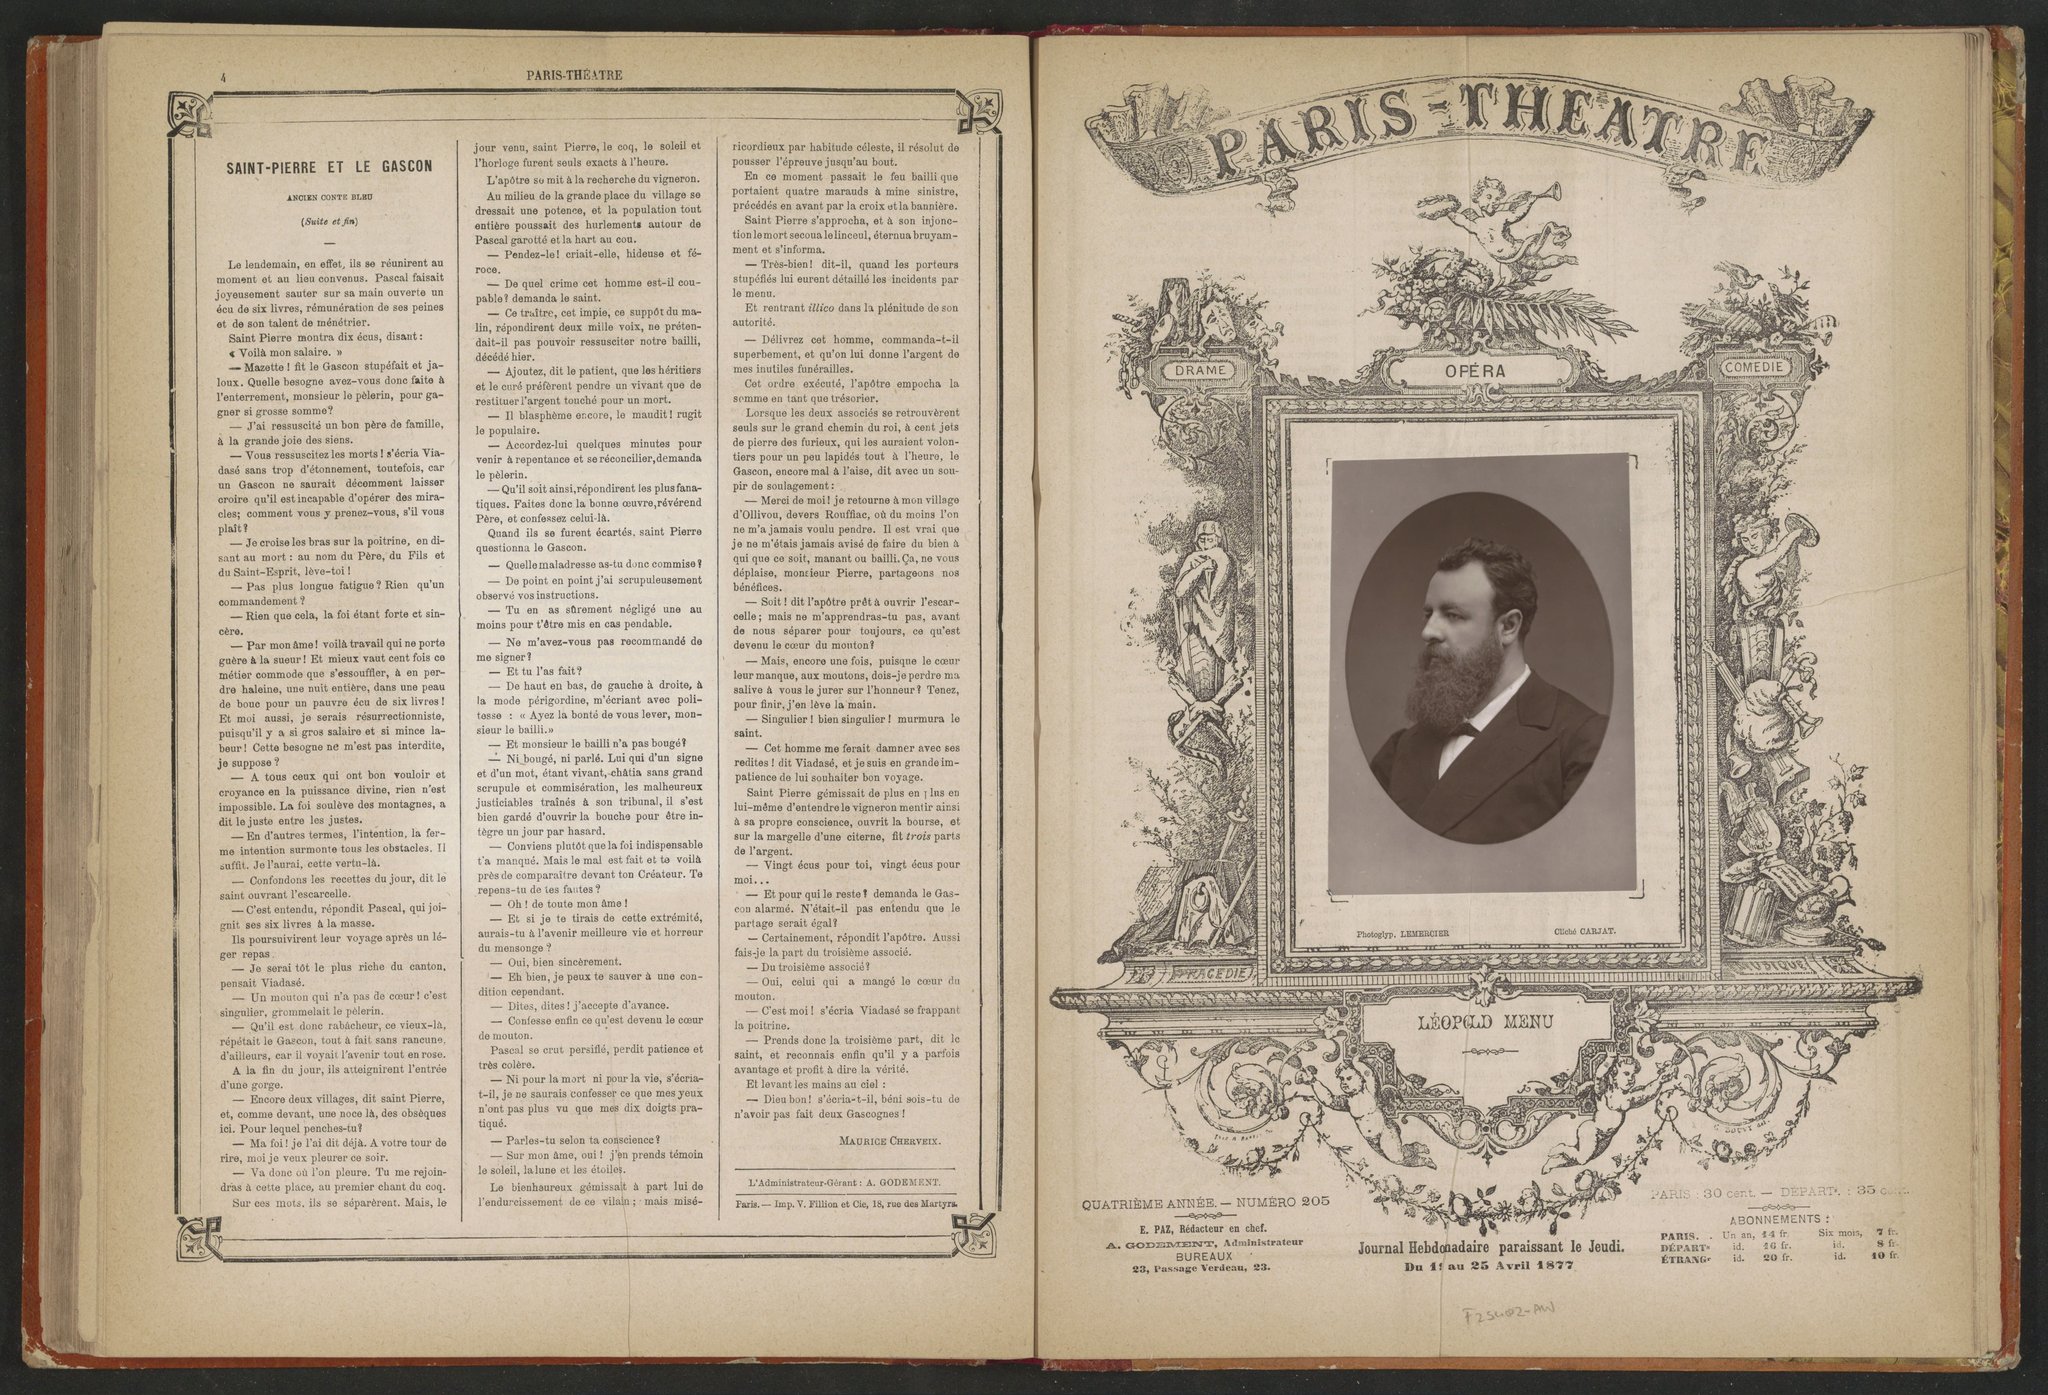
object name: photomechanical print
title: Leopold Menu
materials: paper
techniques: woodburytype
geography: france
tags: portrait of opera-singer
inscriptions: number: ‘Numéro 205’, inscription: ‘Journal Hebdomadaire paraissant le Jeudi, Du 19 au 25 Avril 1877’